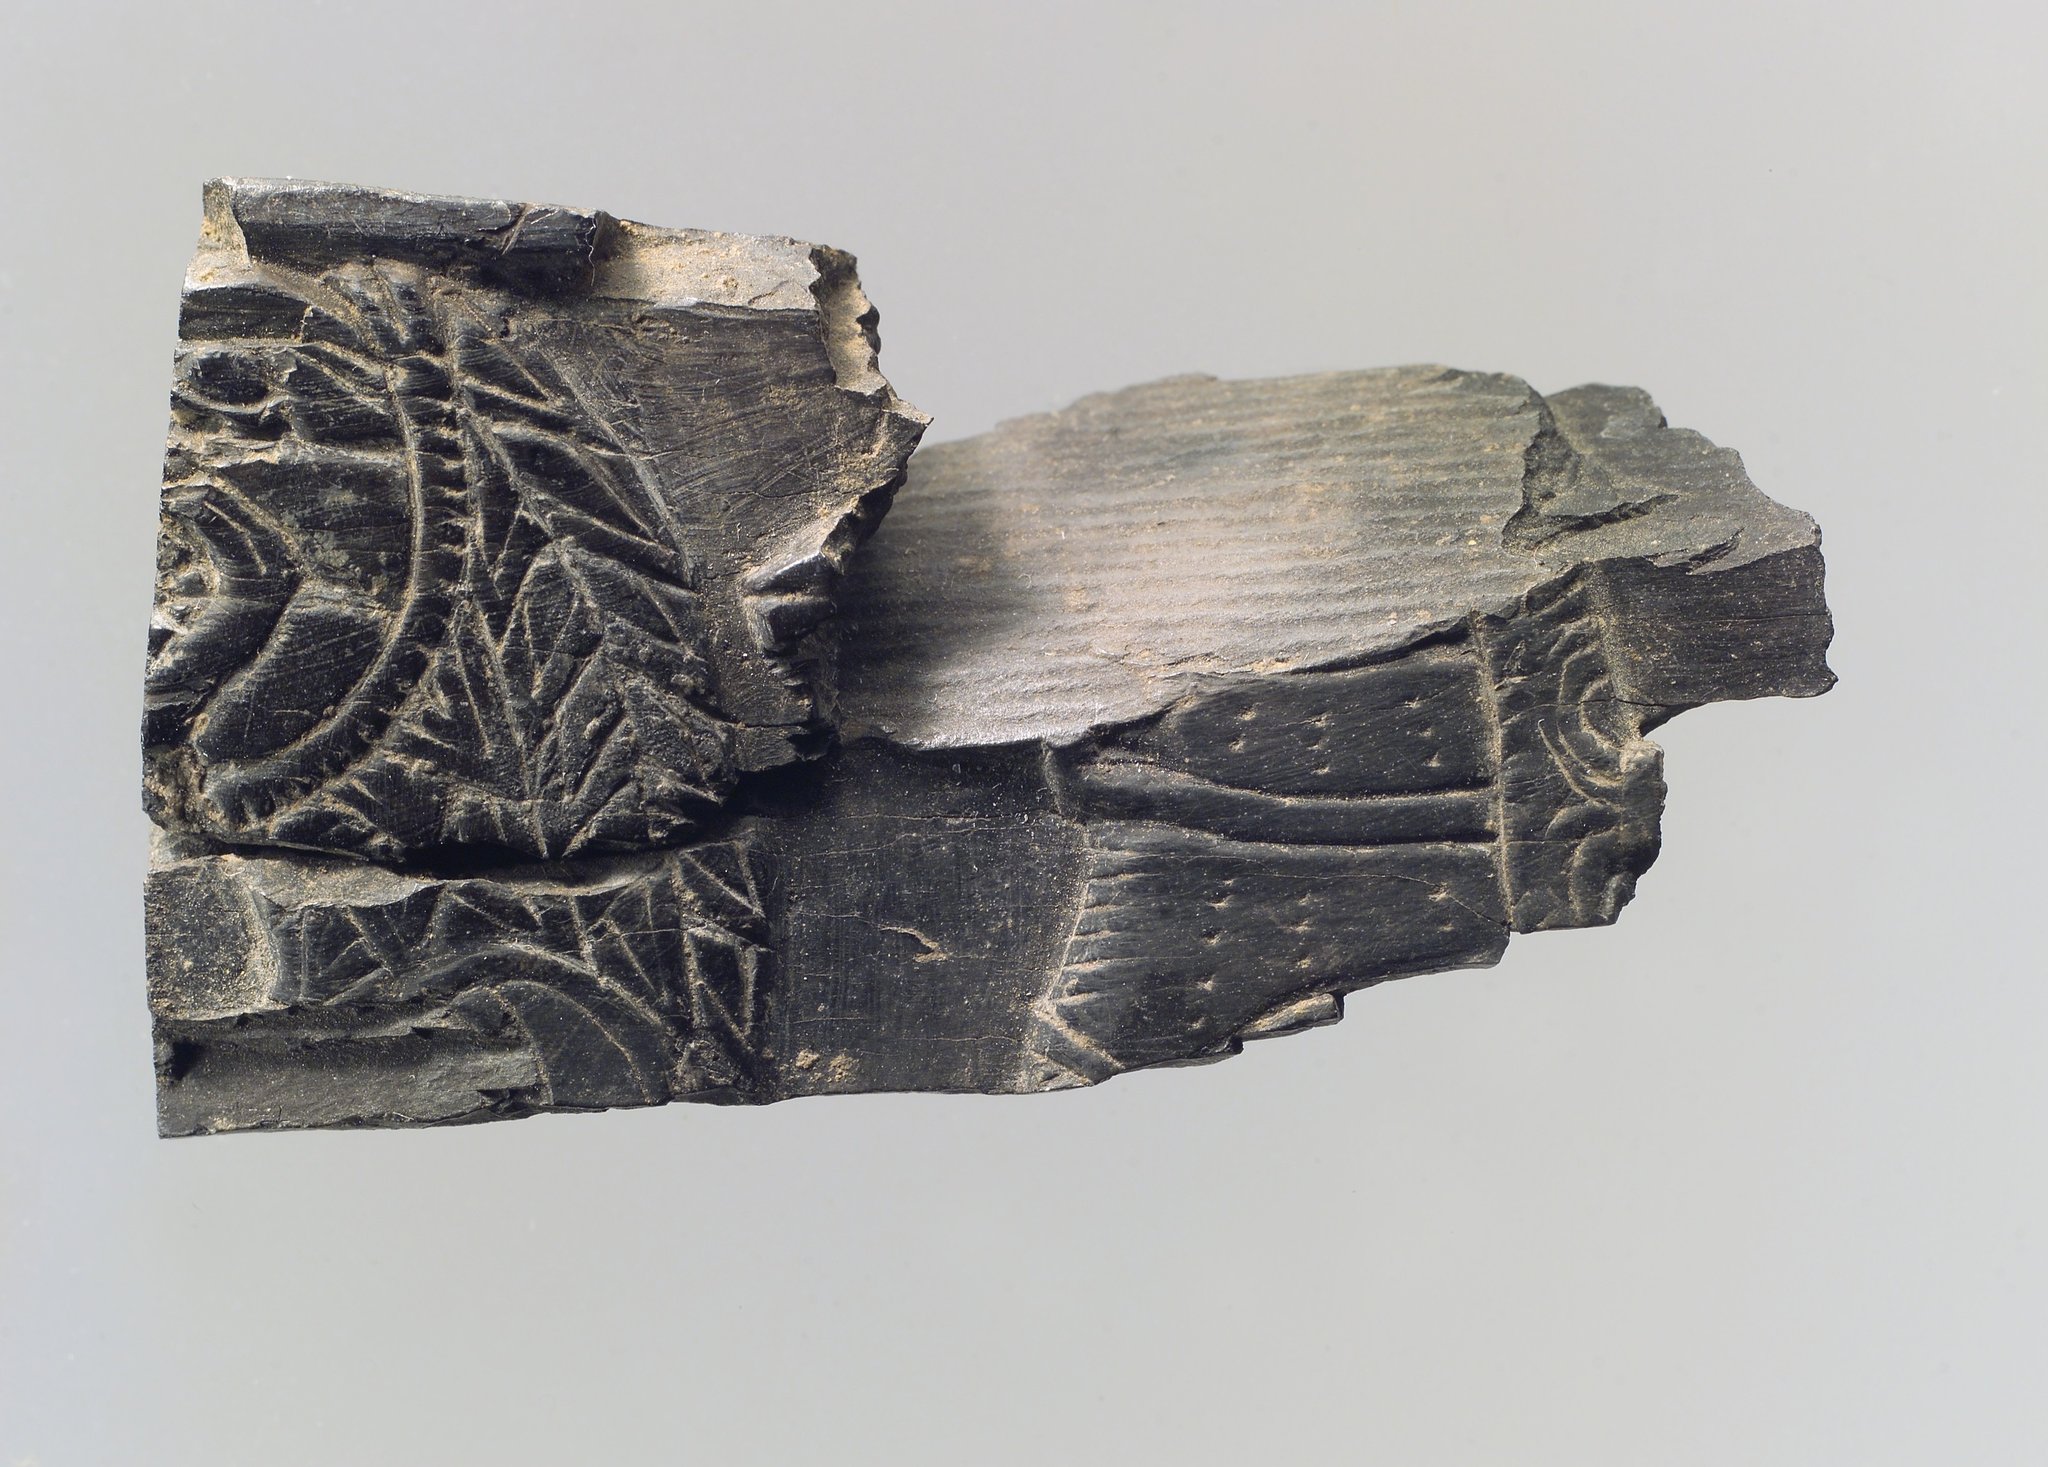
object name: relief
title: Plaque fragment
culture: iranian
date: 900-801 BCE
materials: ivory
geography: iran